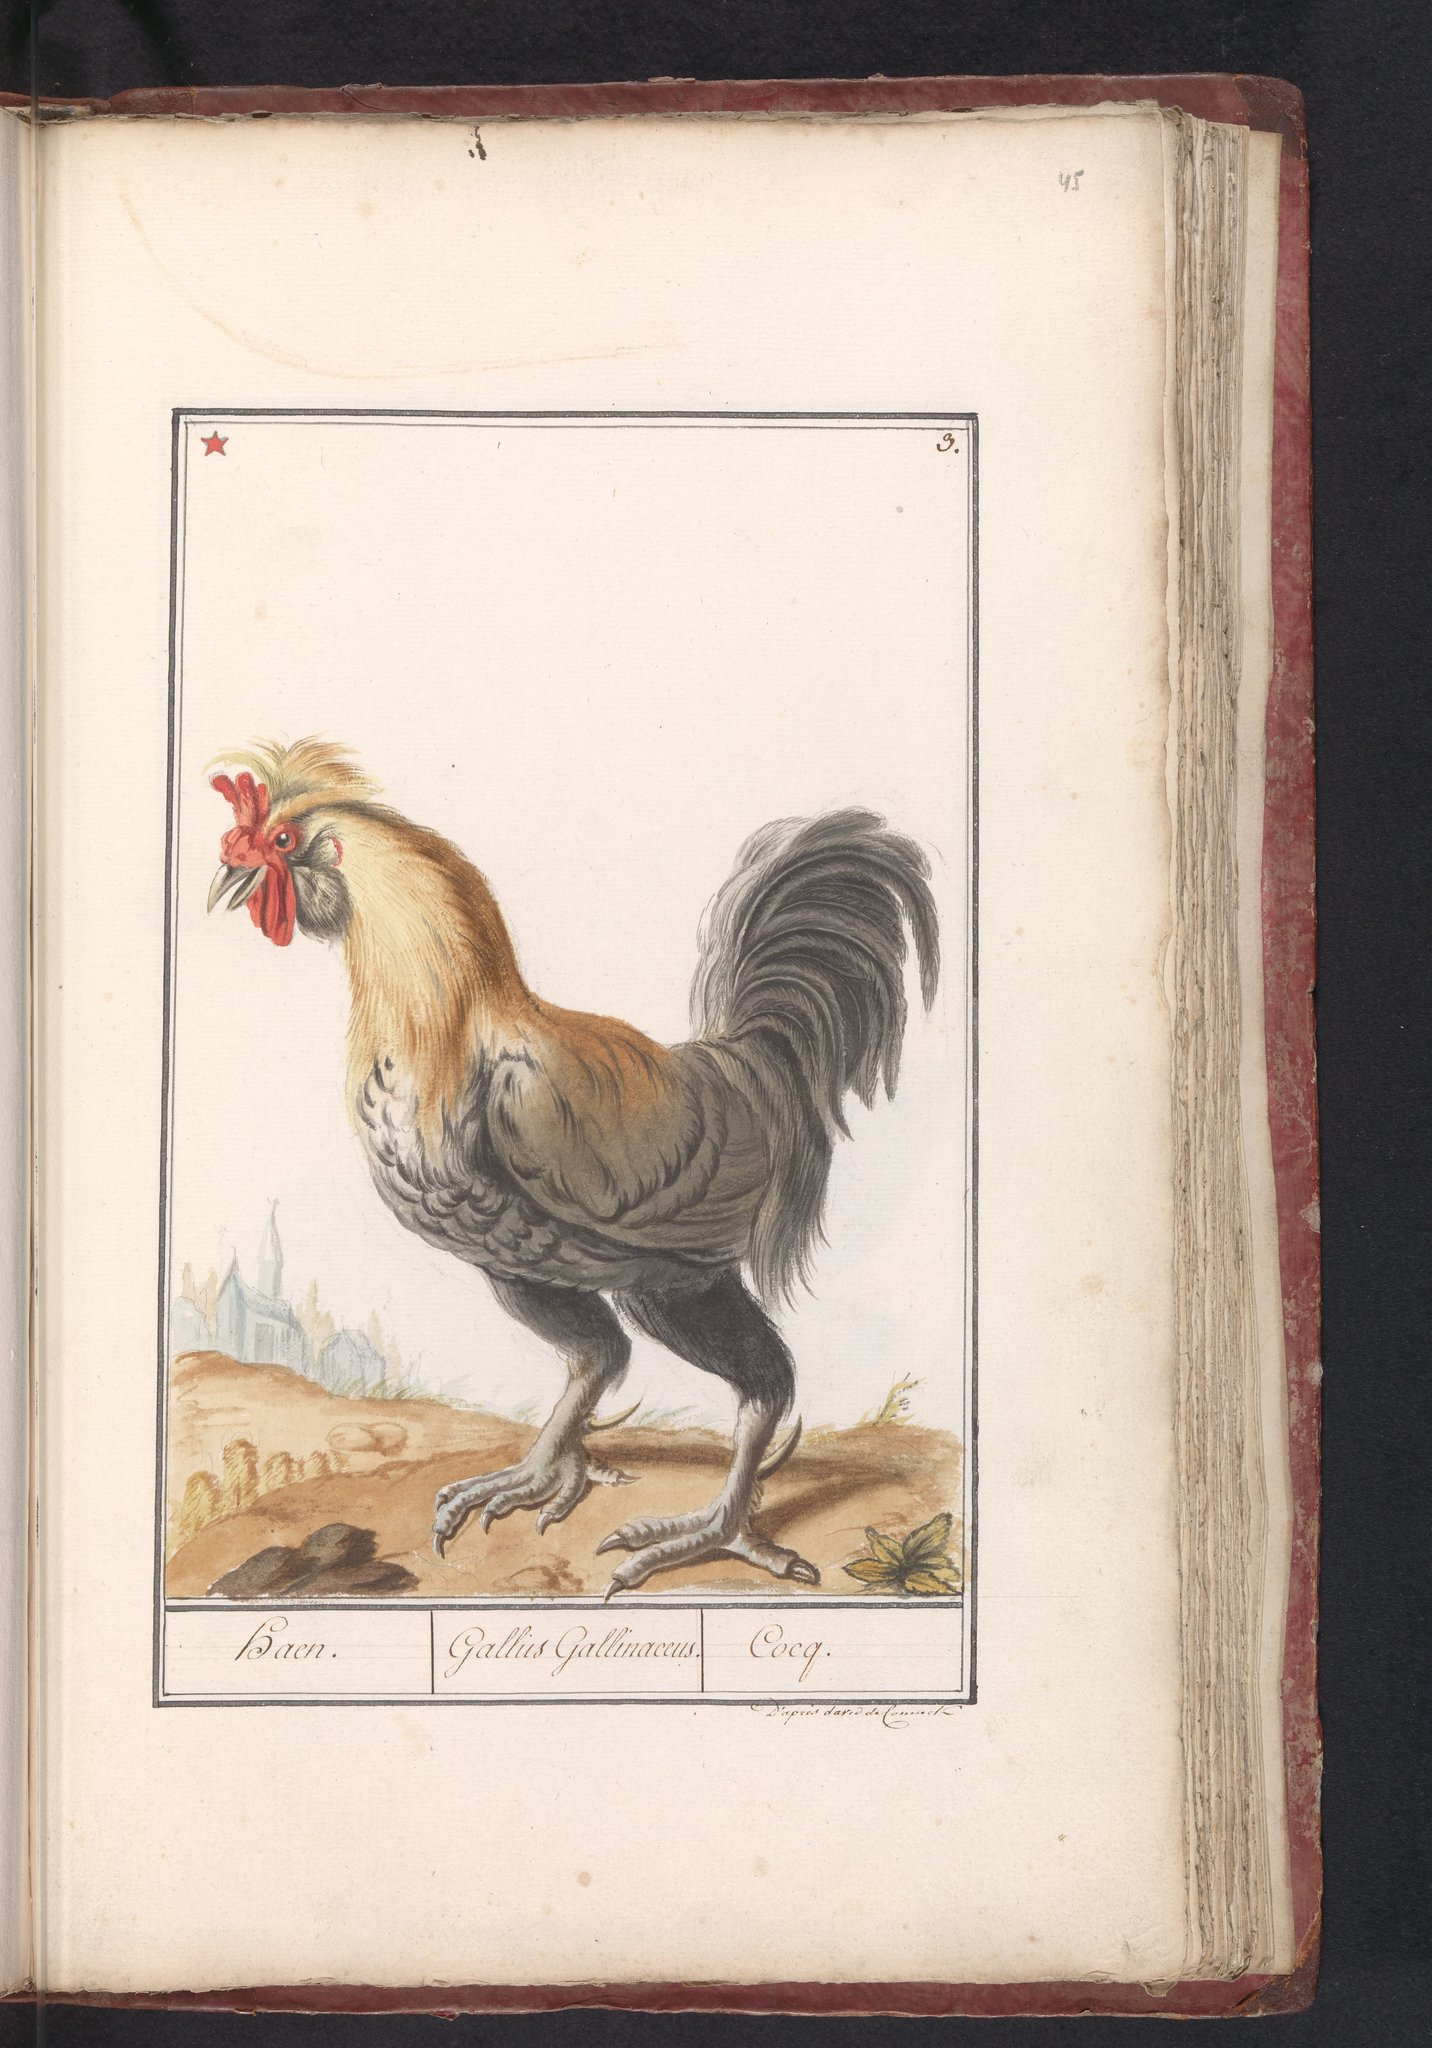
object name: drawing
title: Kip (Gallus gallus domesticus)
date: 1790-1814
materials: paper, pencil, watercolor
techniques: brush, pen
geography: southern netherlands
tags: fowl (cock, hen, chicken, etc.)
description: Kip (haan). Genummerd rechtsboven: 3. Linksboven gemerkt met een rood sterretje. Onderdeel van het eerste album met tekeningen van vogels. Derde van twaalf albums met tekeningen van dieren, vogels en planten bekend rond 1600, gemaakt in opdracht van keizer Rudolf II. Met toelichting in Nederlands, Latijn en Frans.